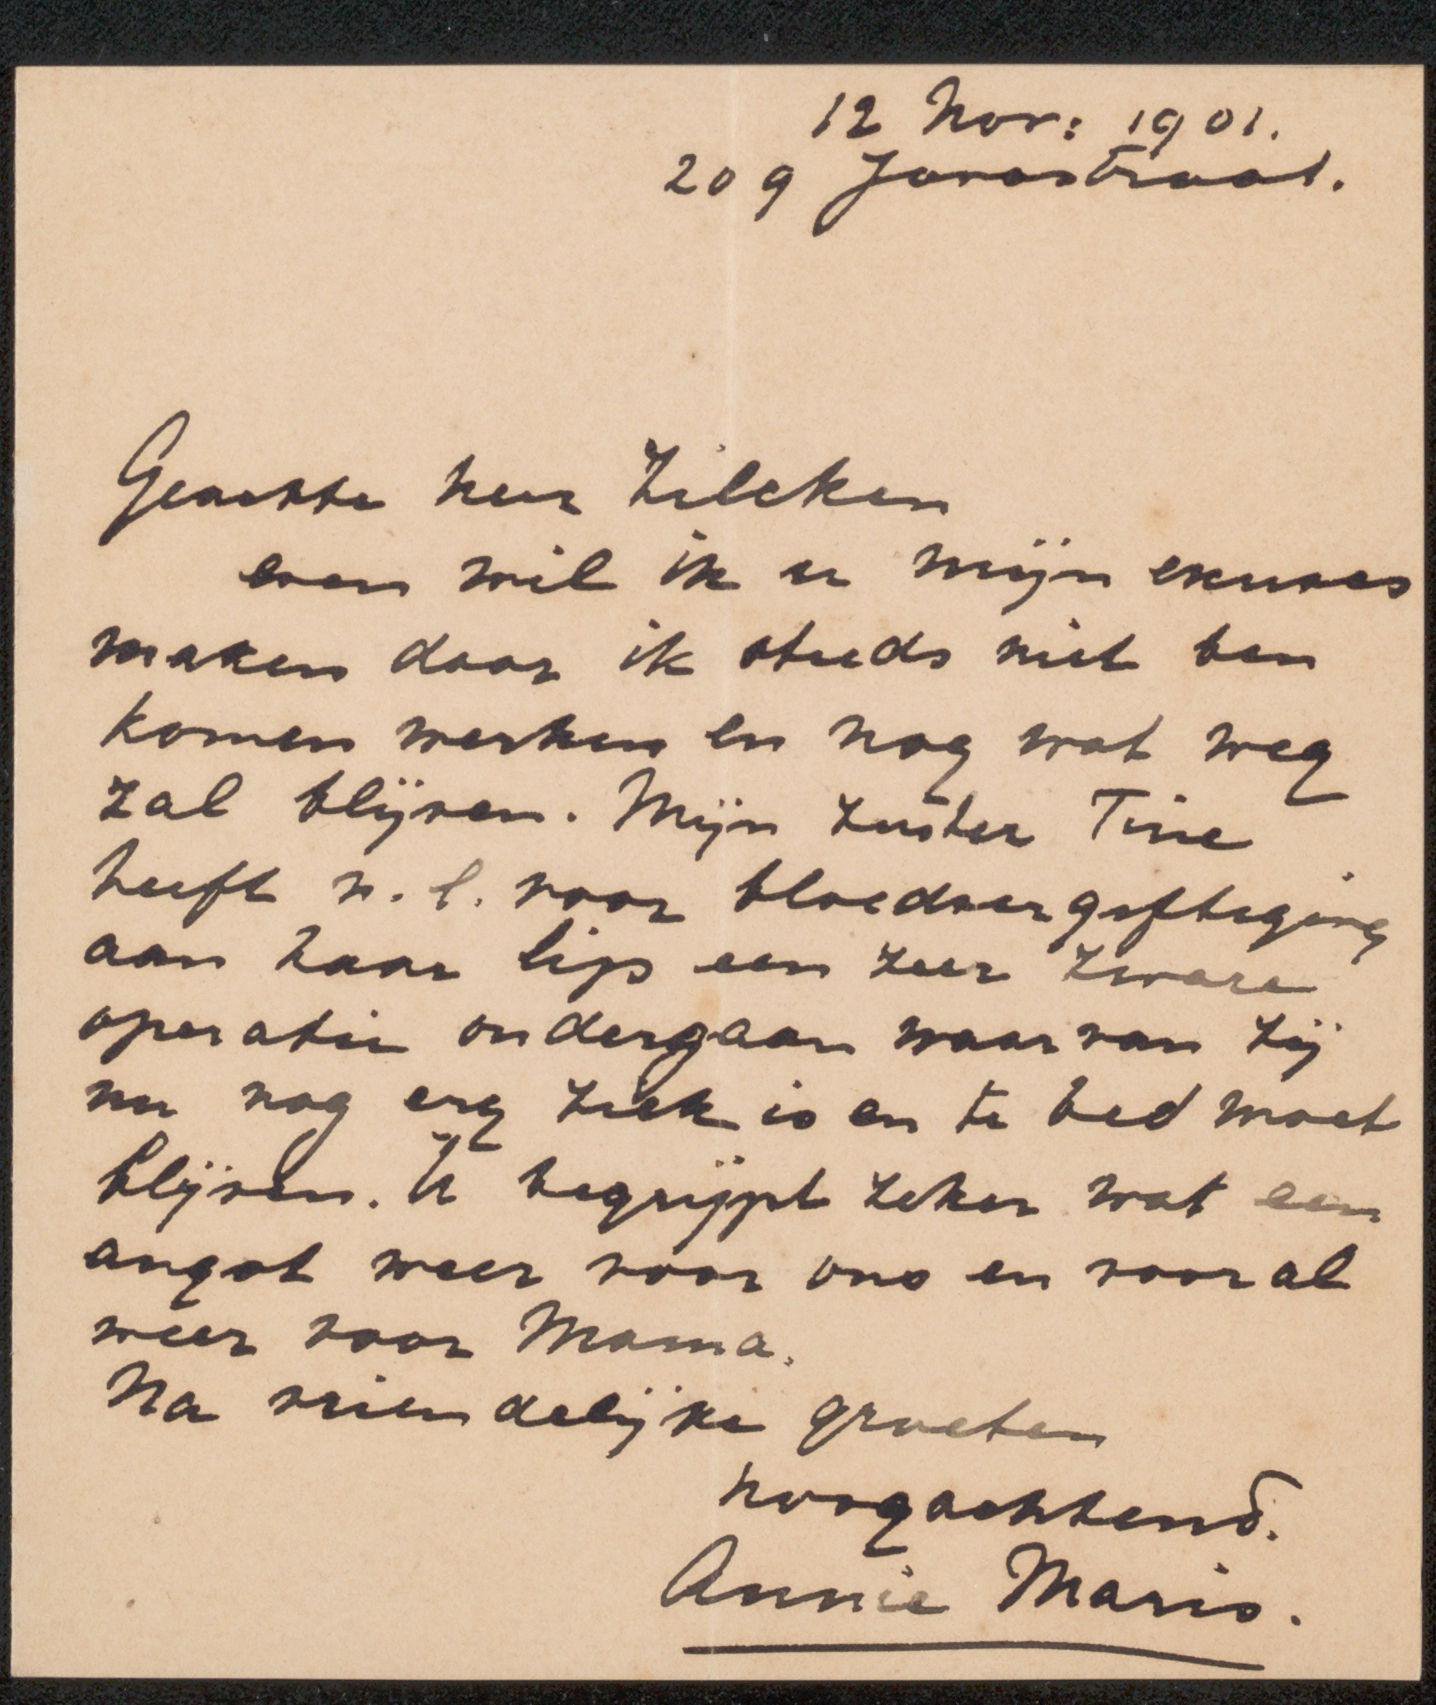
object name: letter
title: Brief aan Philip Zilcken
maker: annie maris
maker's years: 1875-1944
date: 1901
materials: ink, paper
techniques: pen, writing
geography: the hague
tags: painter, philip zilcken, diseases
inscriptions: collector's mark: ‘RPK’